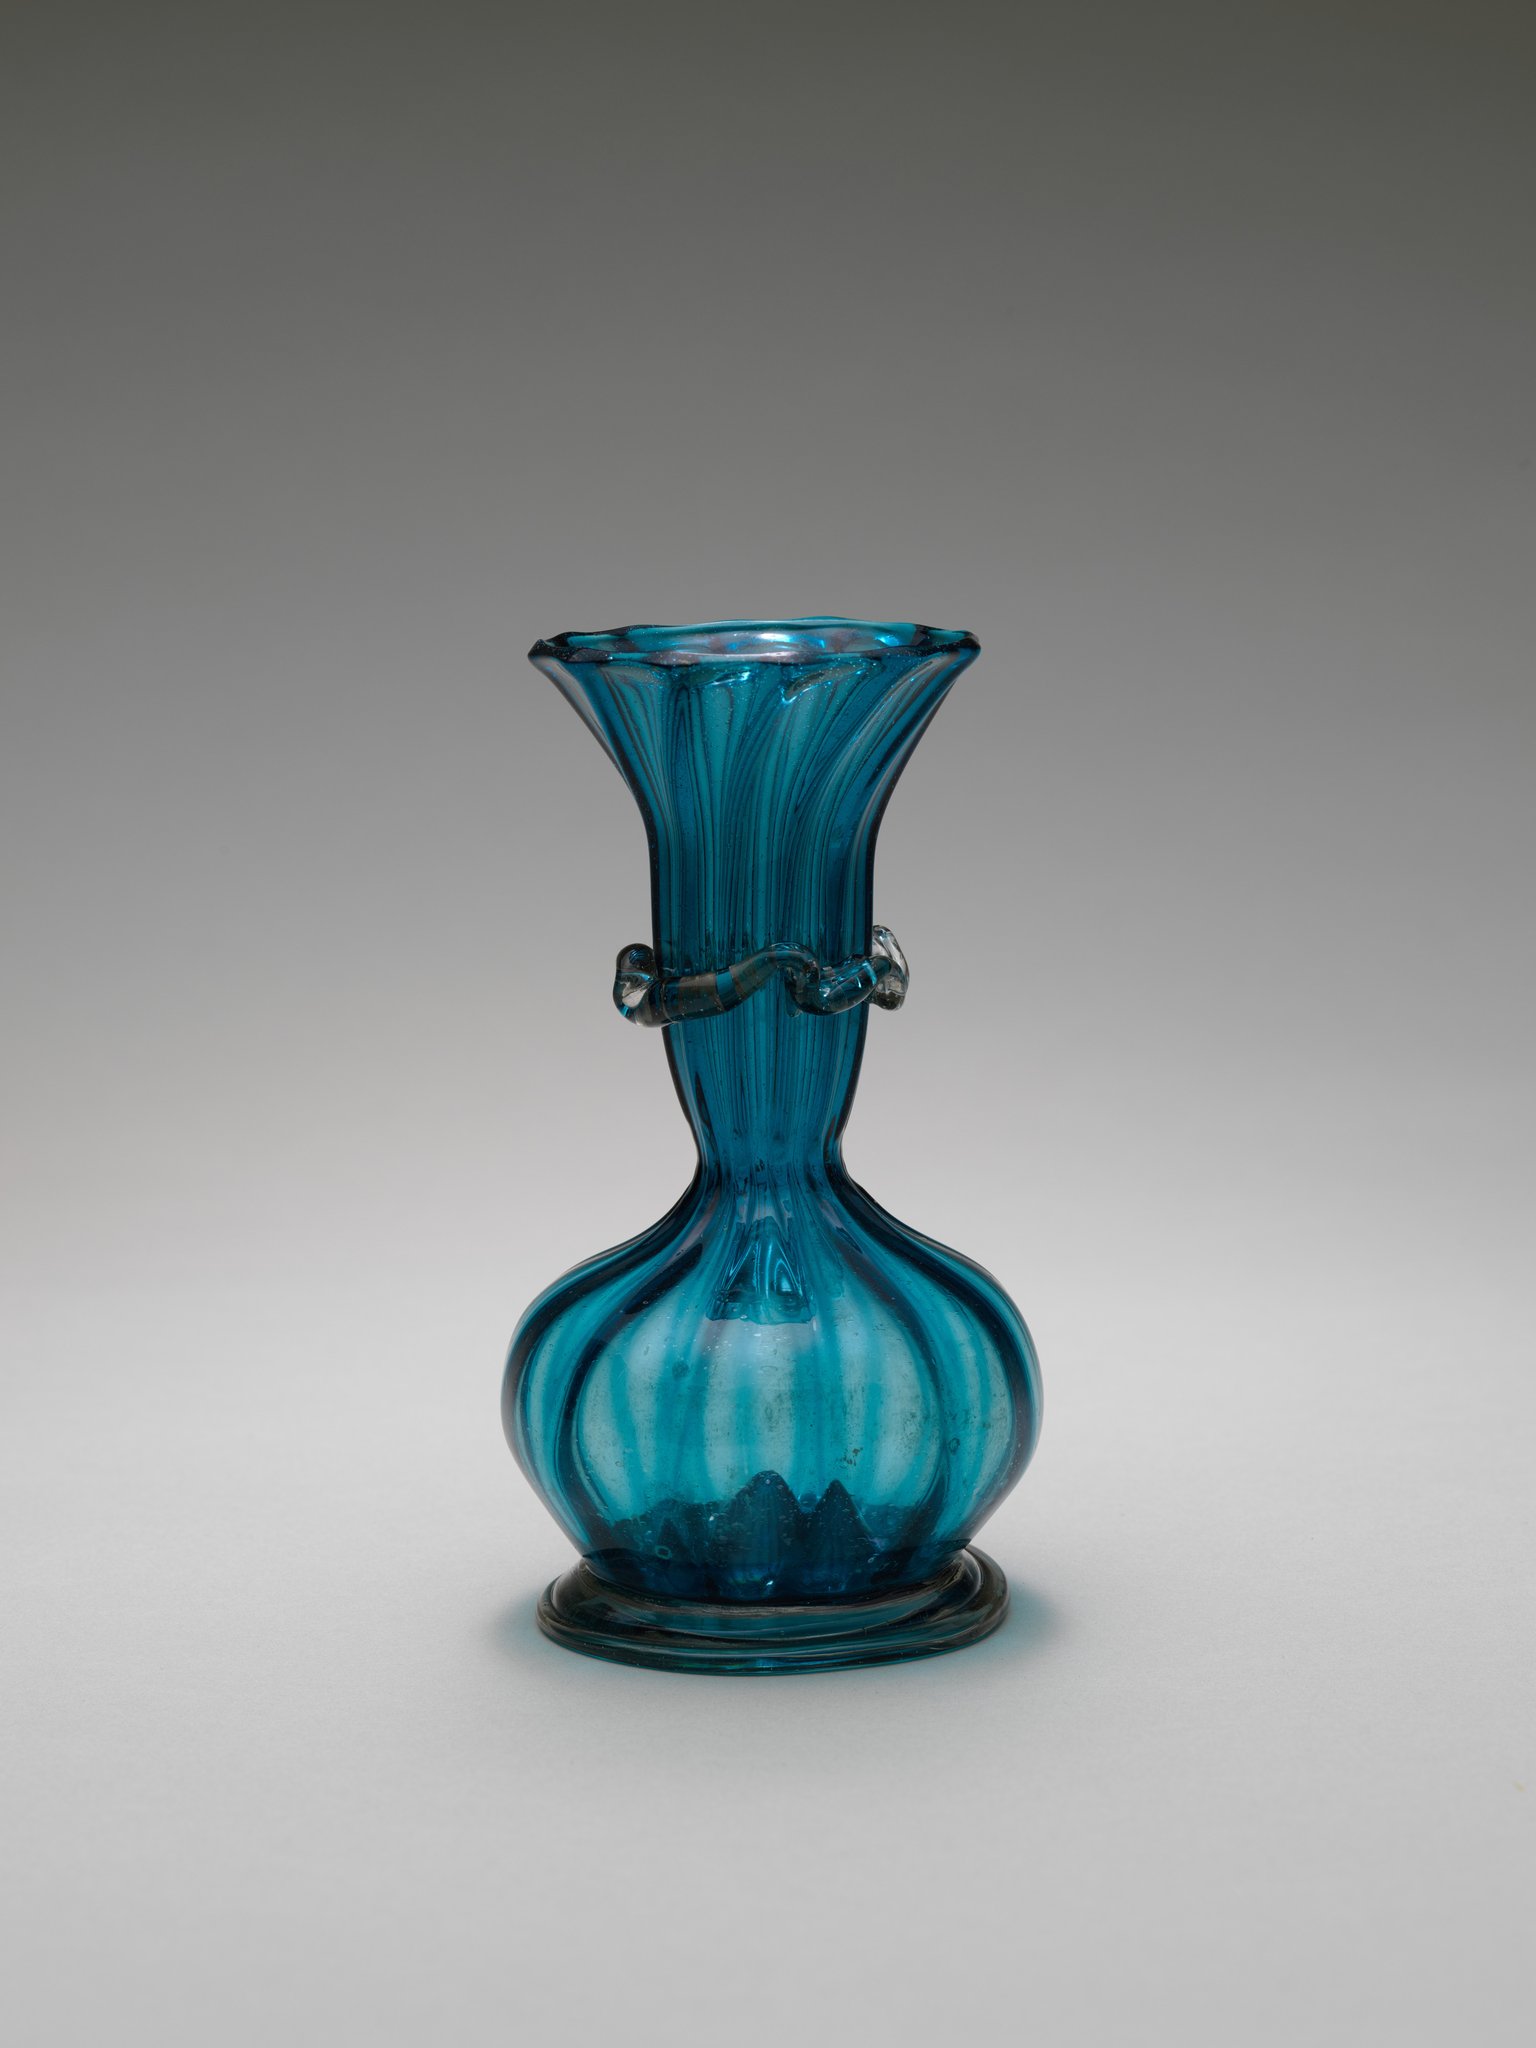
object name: vase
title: Turquoise Glass Bottle with an Onion Shaped Body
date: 1701-1900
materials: glass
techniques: glassblowing, molding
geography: iran